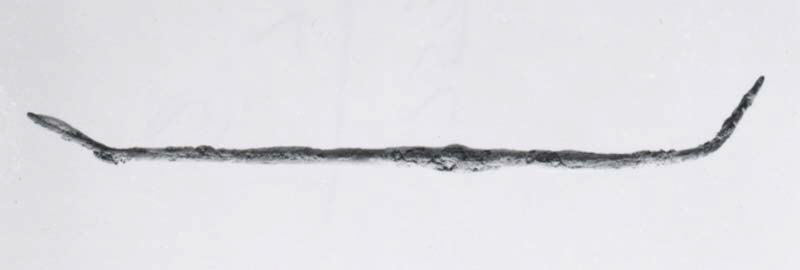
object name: rod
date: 4000-3001 BCE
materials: bronze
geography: mesopotamia